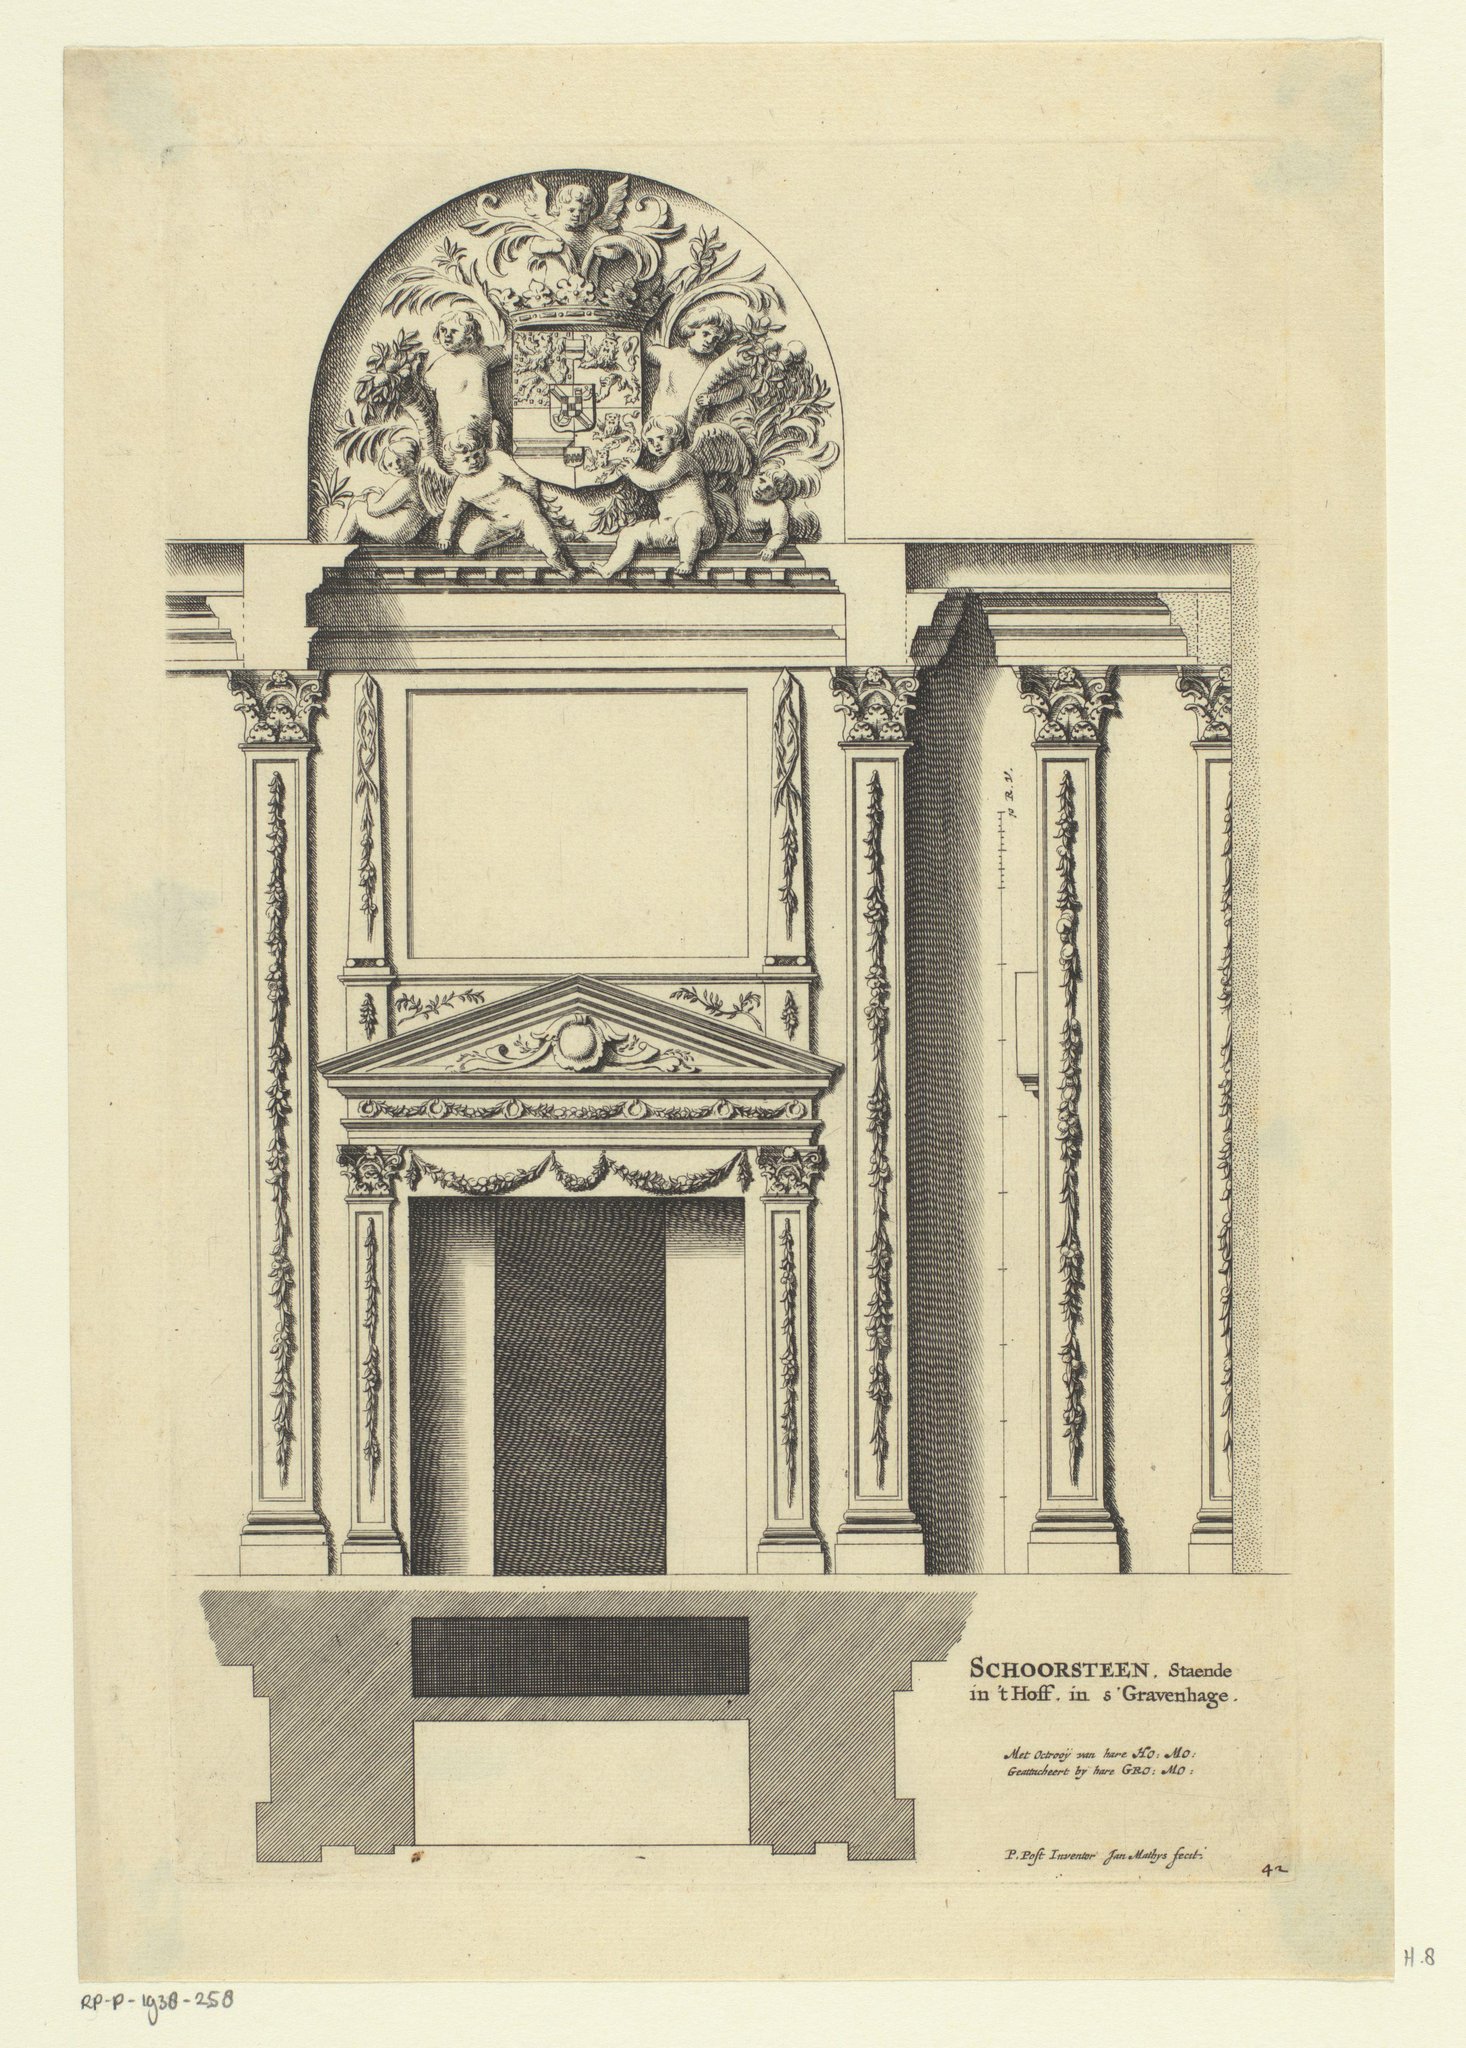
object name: print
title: Ornamentele schoorsteenmantel met putti rond een wapenschild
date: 1665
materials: paper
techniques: engraving, etching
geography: amsterdam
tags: chimney-piece, mantelpiece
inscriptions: collector's mark: Lugt 2760, collector's mark: Lugt 2228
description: Ornamentele schoorsteenmantel met boven putti rond een wapenschild in het Binnenhof te Den Haag. Rechtsonder genummerd: 42.